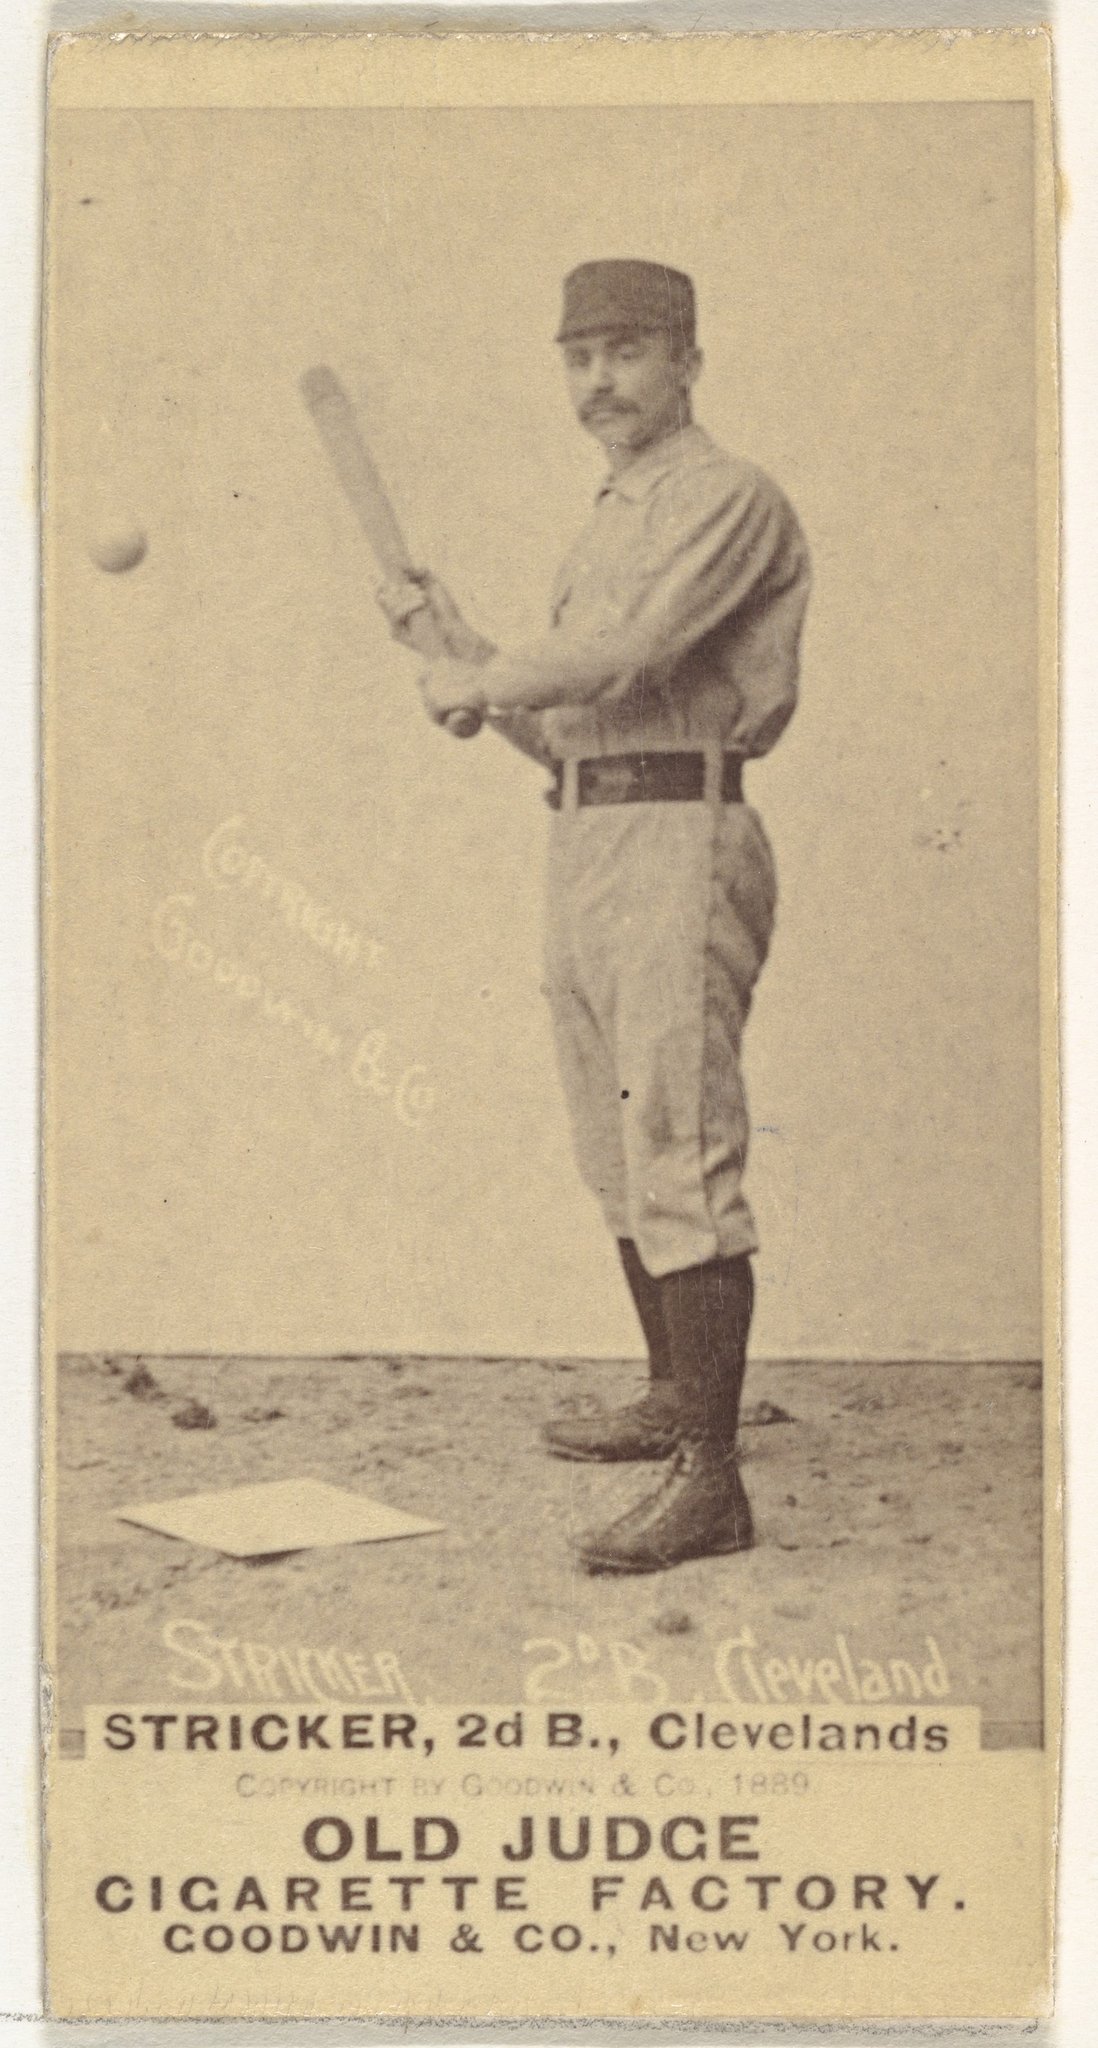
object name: baseball card, photograph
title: John A. "Cub" Stricker, 2nd Base, Cleveland, from the Old Judge series (N172) for Old Judge Cigarettes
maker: goodwin & company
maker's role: publisher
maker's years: 1850-1950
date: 1889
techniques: albumen silver print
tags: men,portraits,baseball,athletes